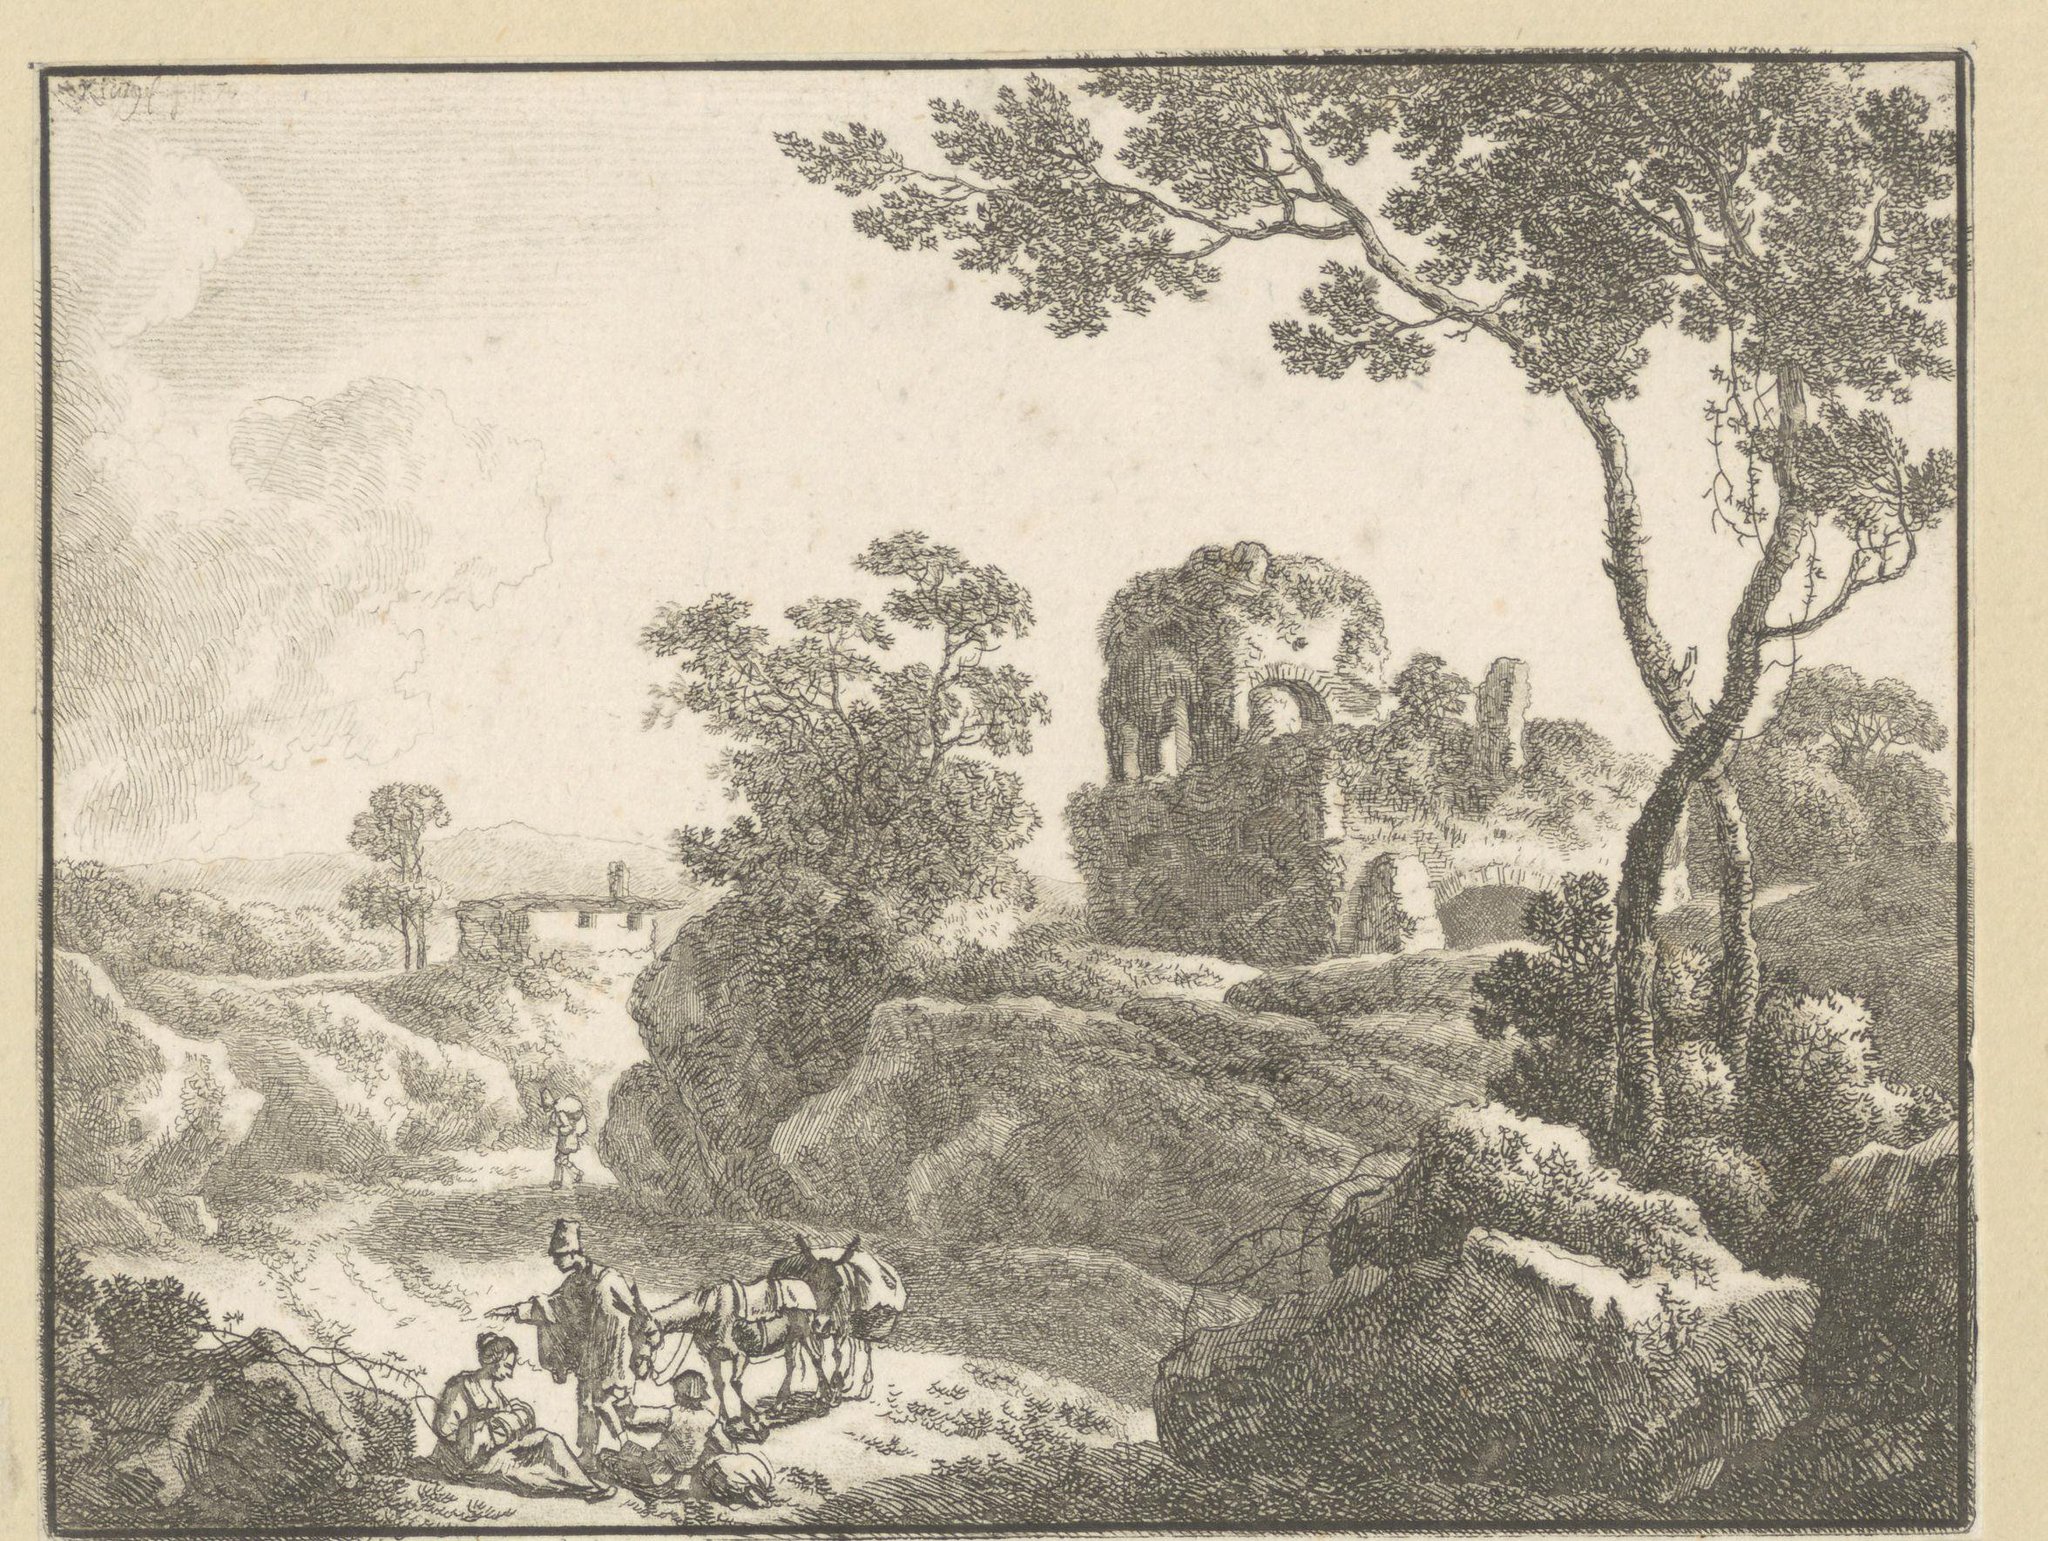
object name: print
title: Landschap met ruïne en rustende reizigers bij hun ezels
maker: johann christian klengel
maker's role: print maker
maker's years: 1751-1824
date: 1770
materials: paper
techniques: etching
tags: ass, donkey, (traveller) resting in the open air, landscape with ruins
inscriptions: collector's mark: Lugt 240